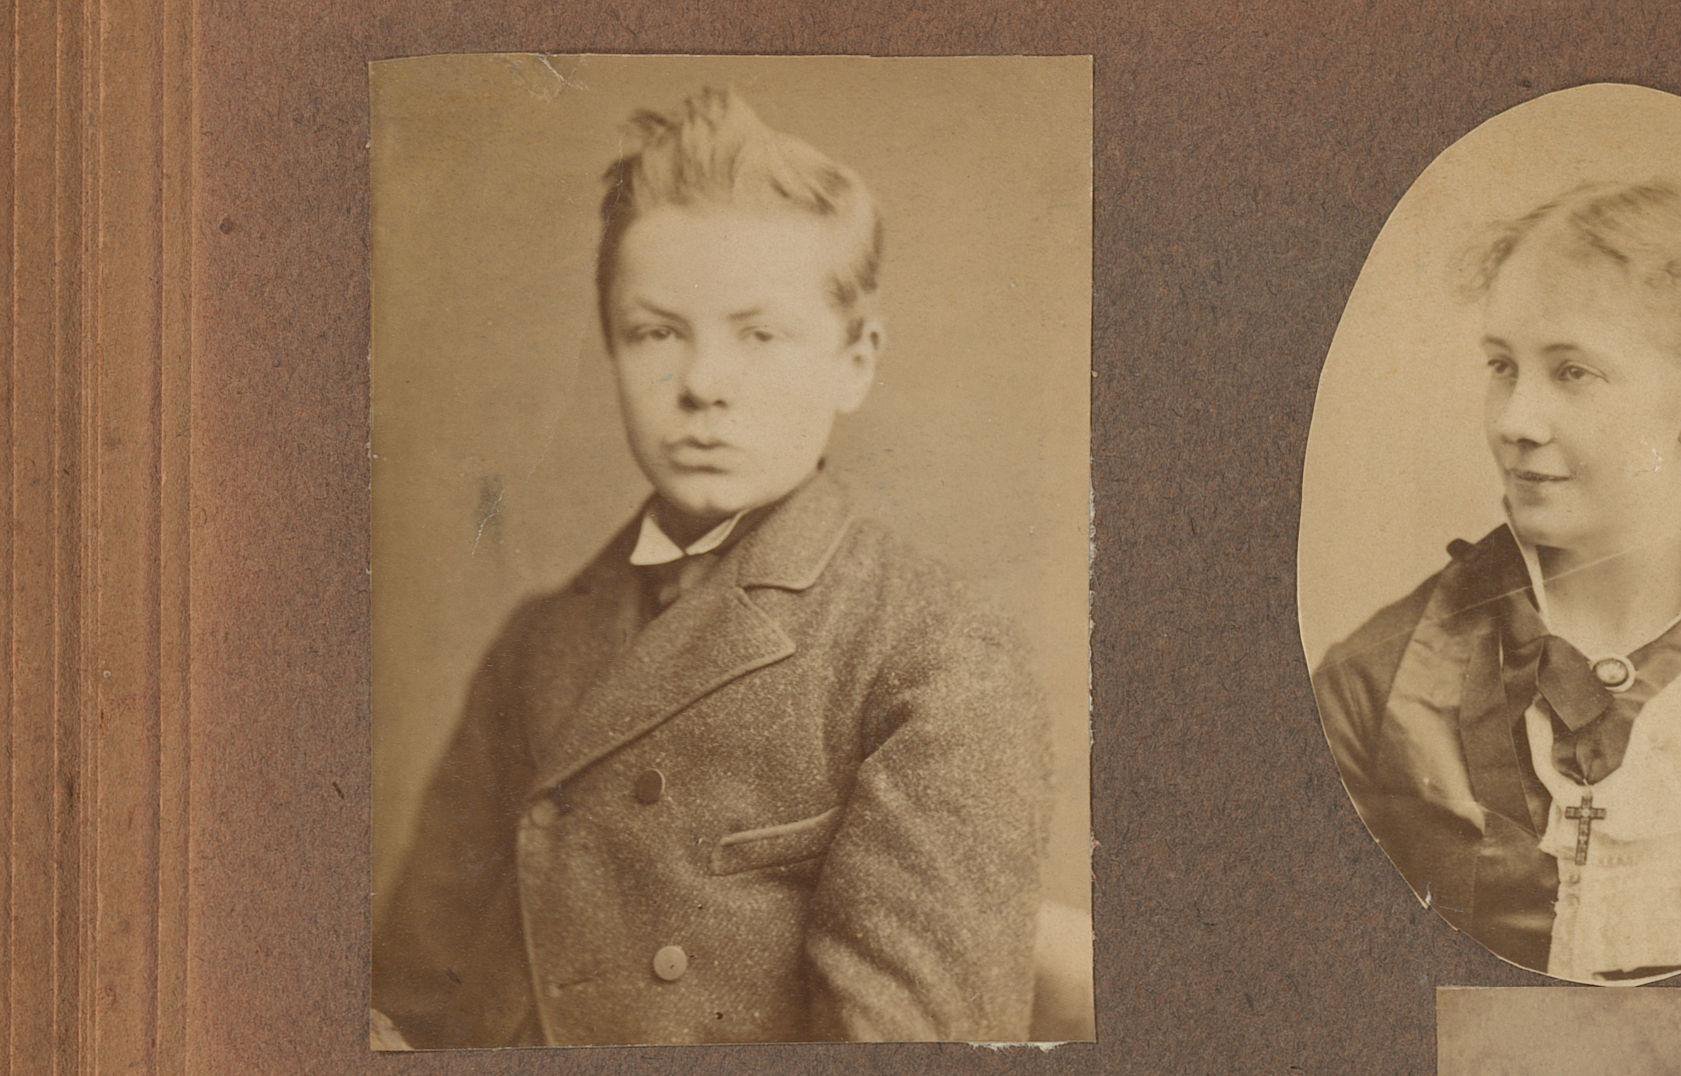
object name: photograph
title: Portret van jongen met lichtgekleurd haar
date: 1877-1884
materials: photographic support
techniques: photography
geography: amsterdam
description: Foto op bruin albumblad 16 van familiealbum van Alphons Diepenbrock.